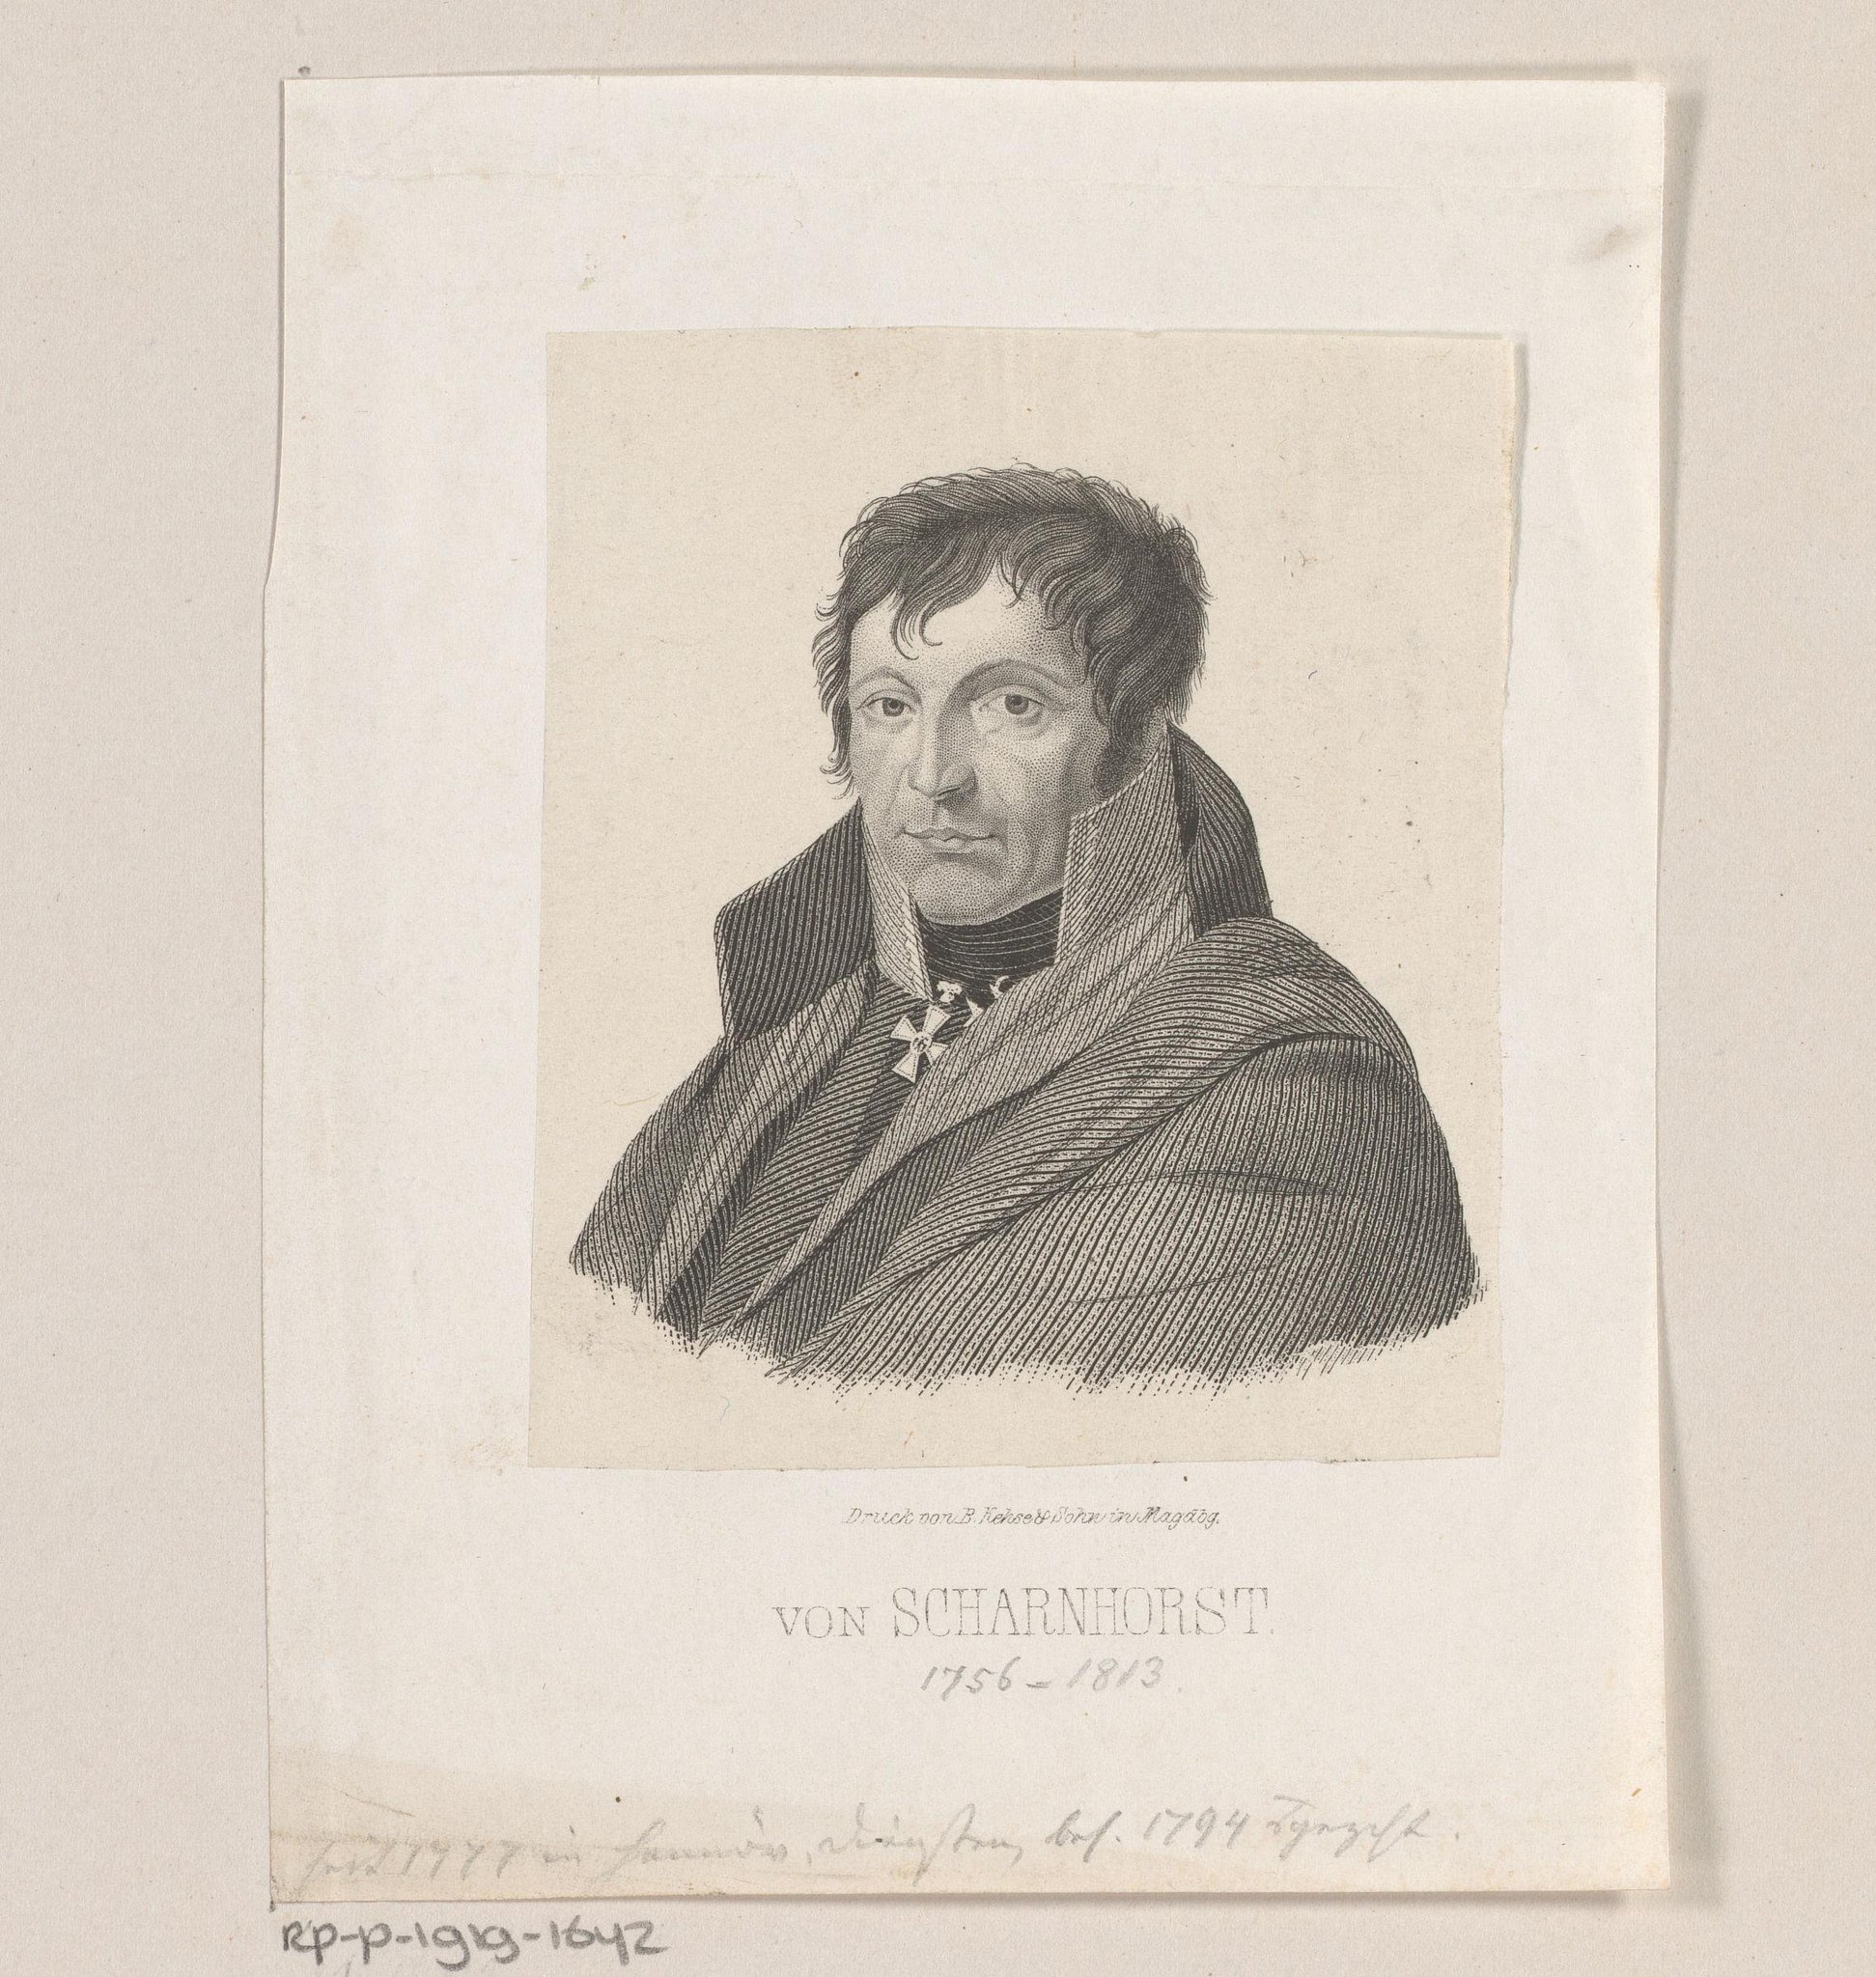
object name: print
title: Portret van Gerhard von Scharnhorst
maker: Anonymous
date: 1830-1840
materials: paper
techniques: etching, snipping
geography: magdeburg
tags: prague, knighthood order, commander-in-chief, general, marshal, historical persons, (military) uniforms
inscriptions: collector's mark: Lugt 2228